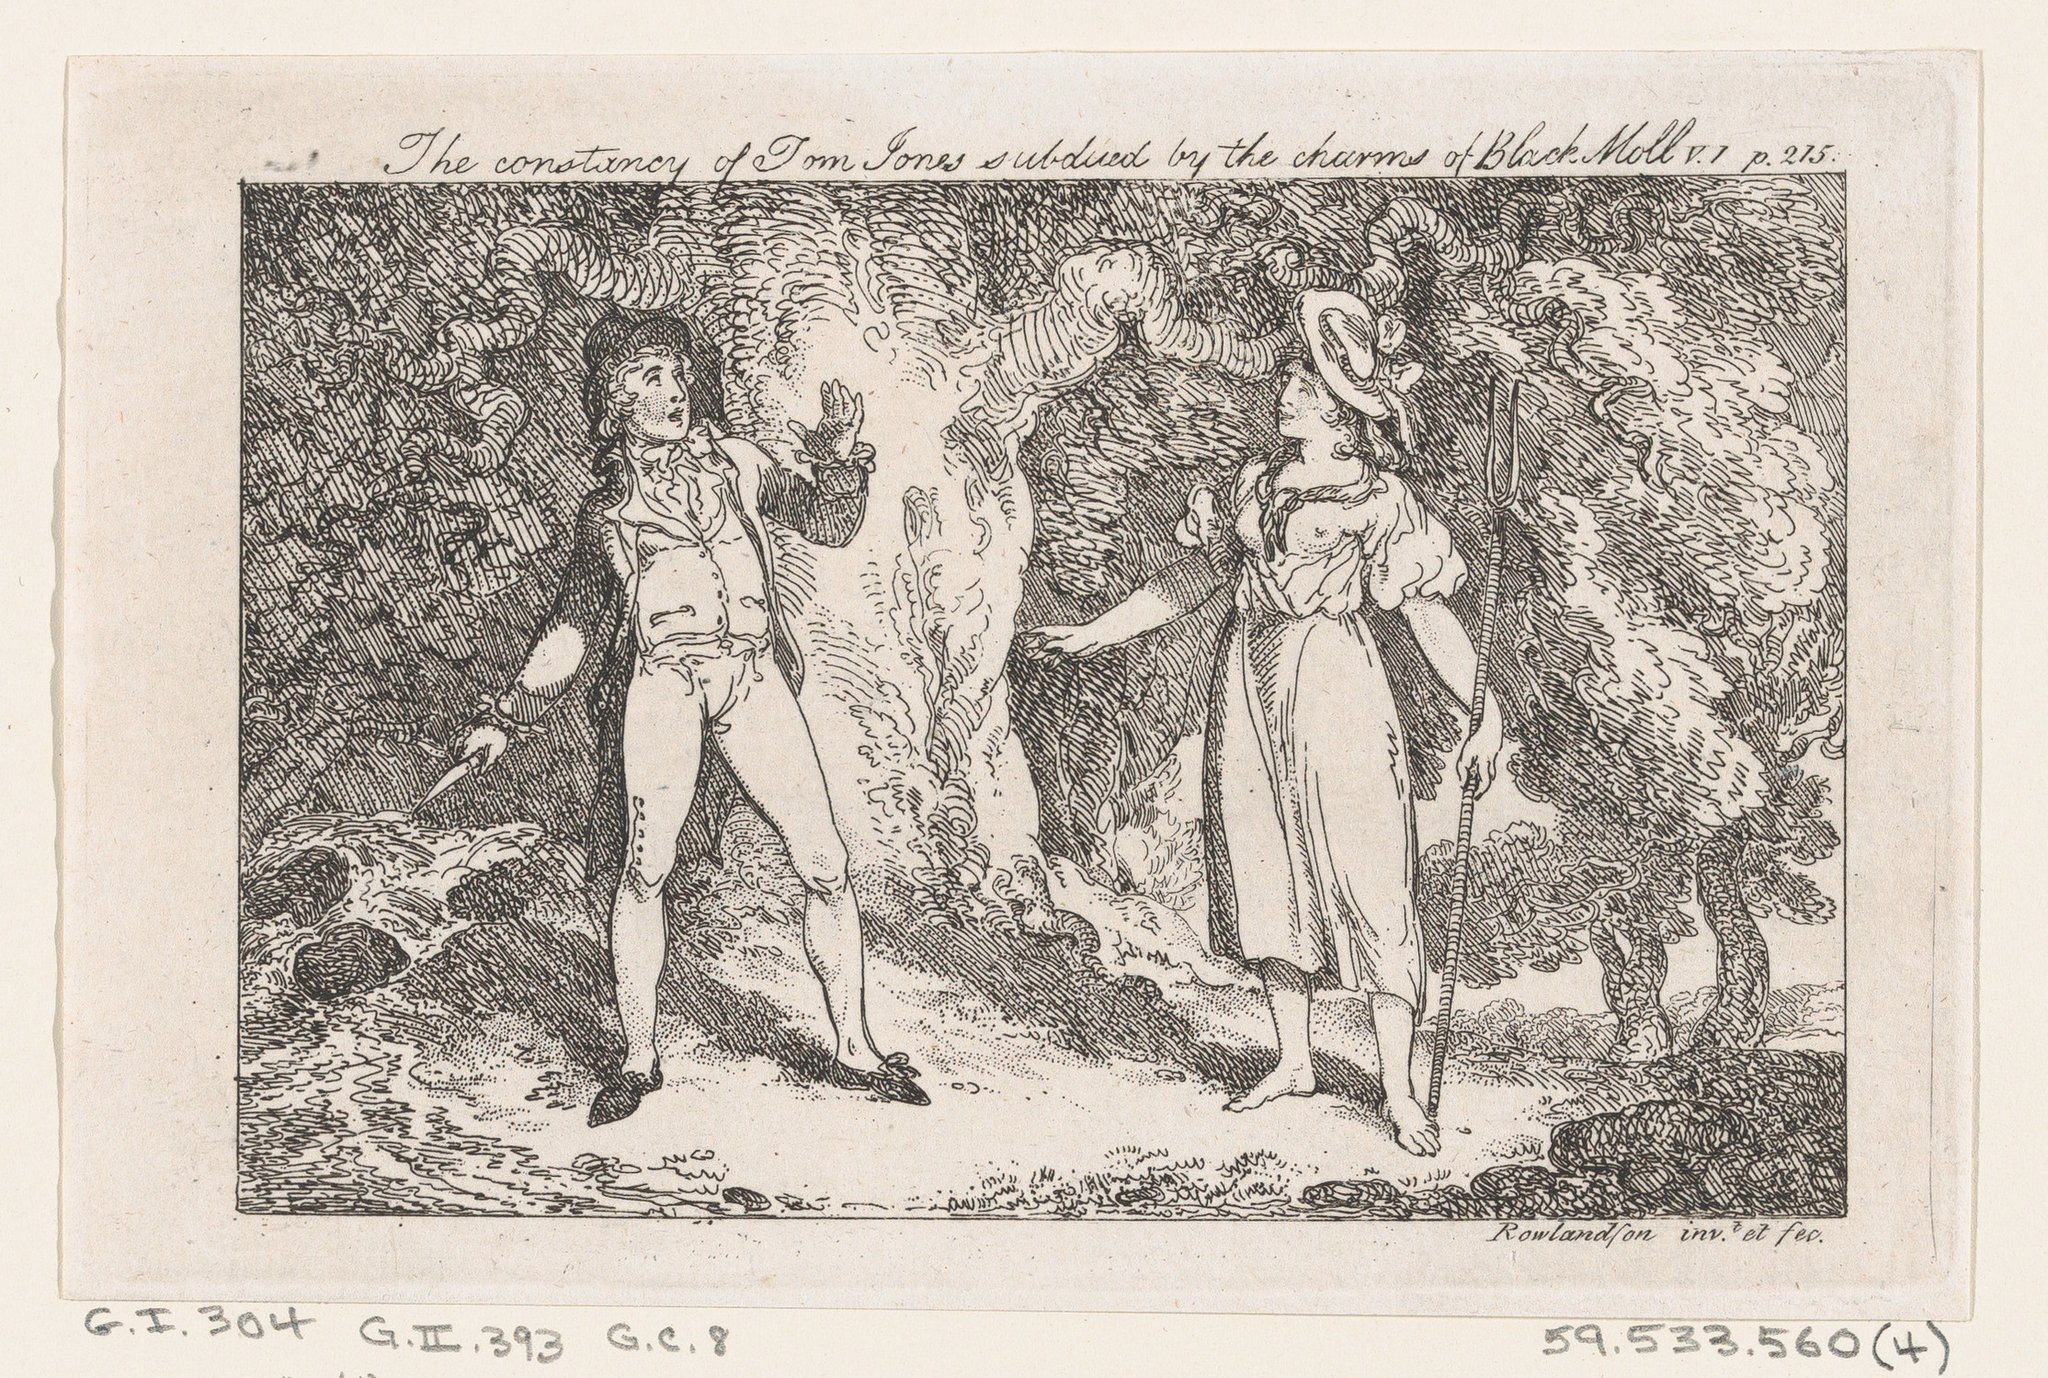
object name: print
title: The constancy of Tom Jones subdued by the charms of Black Moll, from "The History of Tom Jones, a Foundling"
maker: thomas rowlandson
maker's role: artist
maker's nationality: british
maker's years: 1757-1827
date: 1792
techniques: etching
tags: men,women